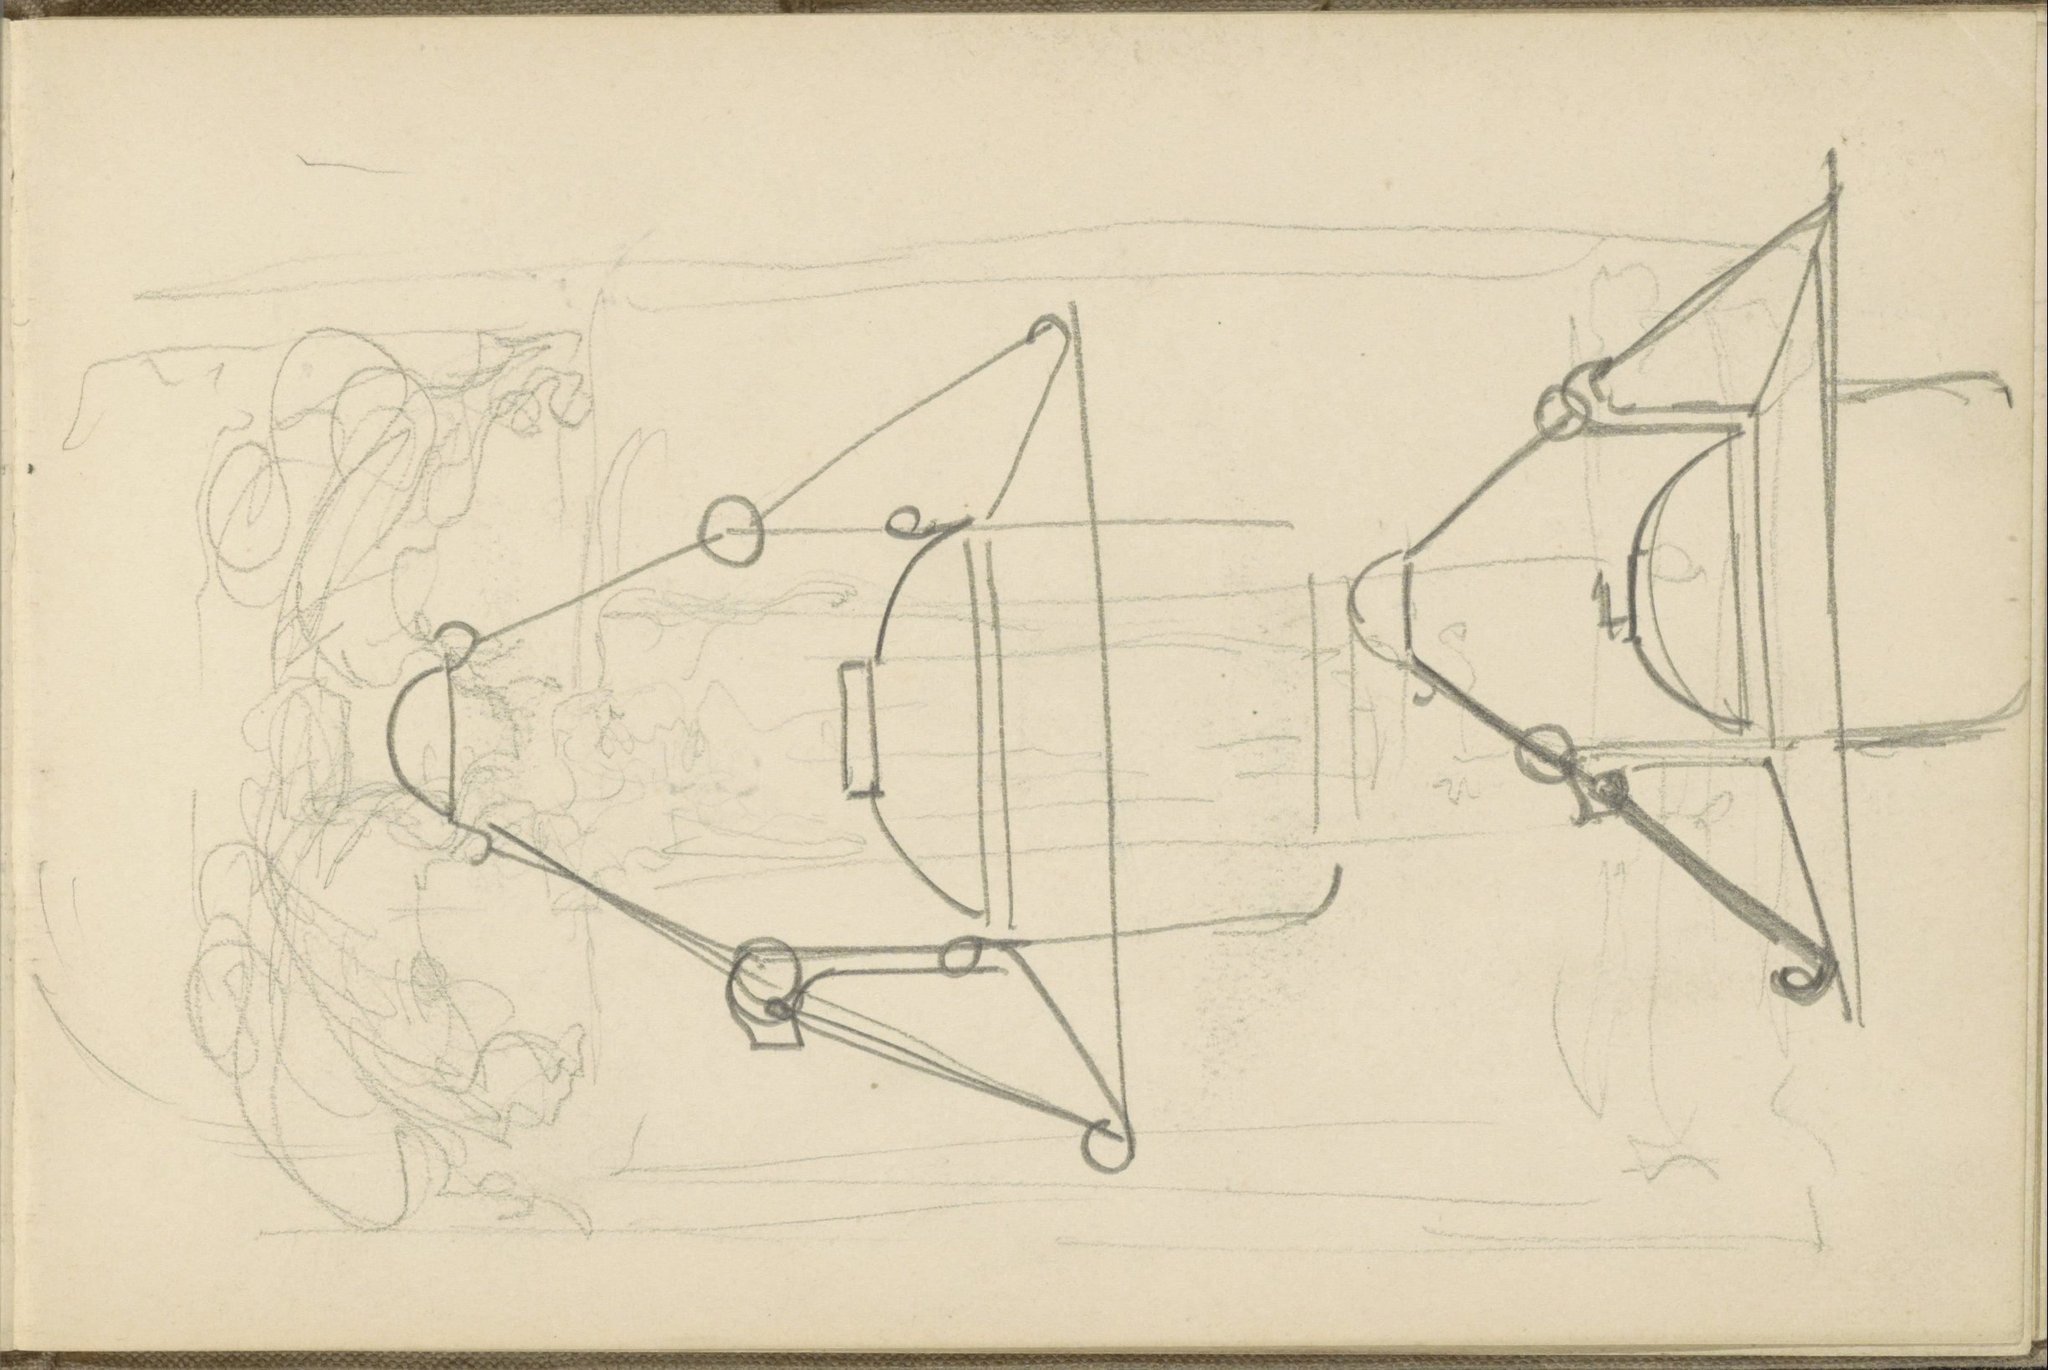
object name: sketchbook leaf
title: Ontwerpen voor elektrische lampen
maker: carel adolph lion cachet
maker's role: draughtsman, print maker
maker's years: 1864-1945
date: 1905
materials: paper, pencil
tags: electric lamp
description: Blad 13 recto uit een schetsboek met 27 bladen.